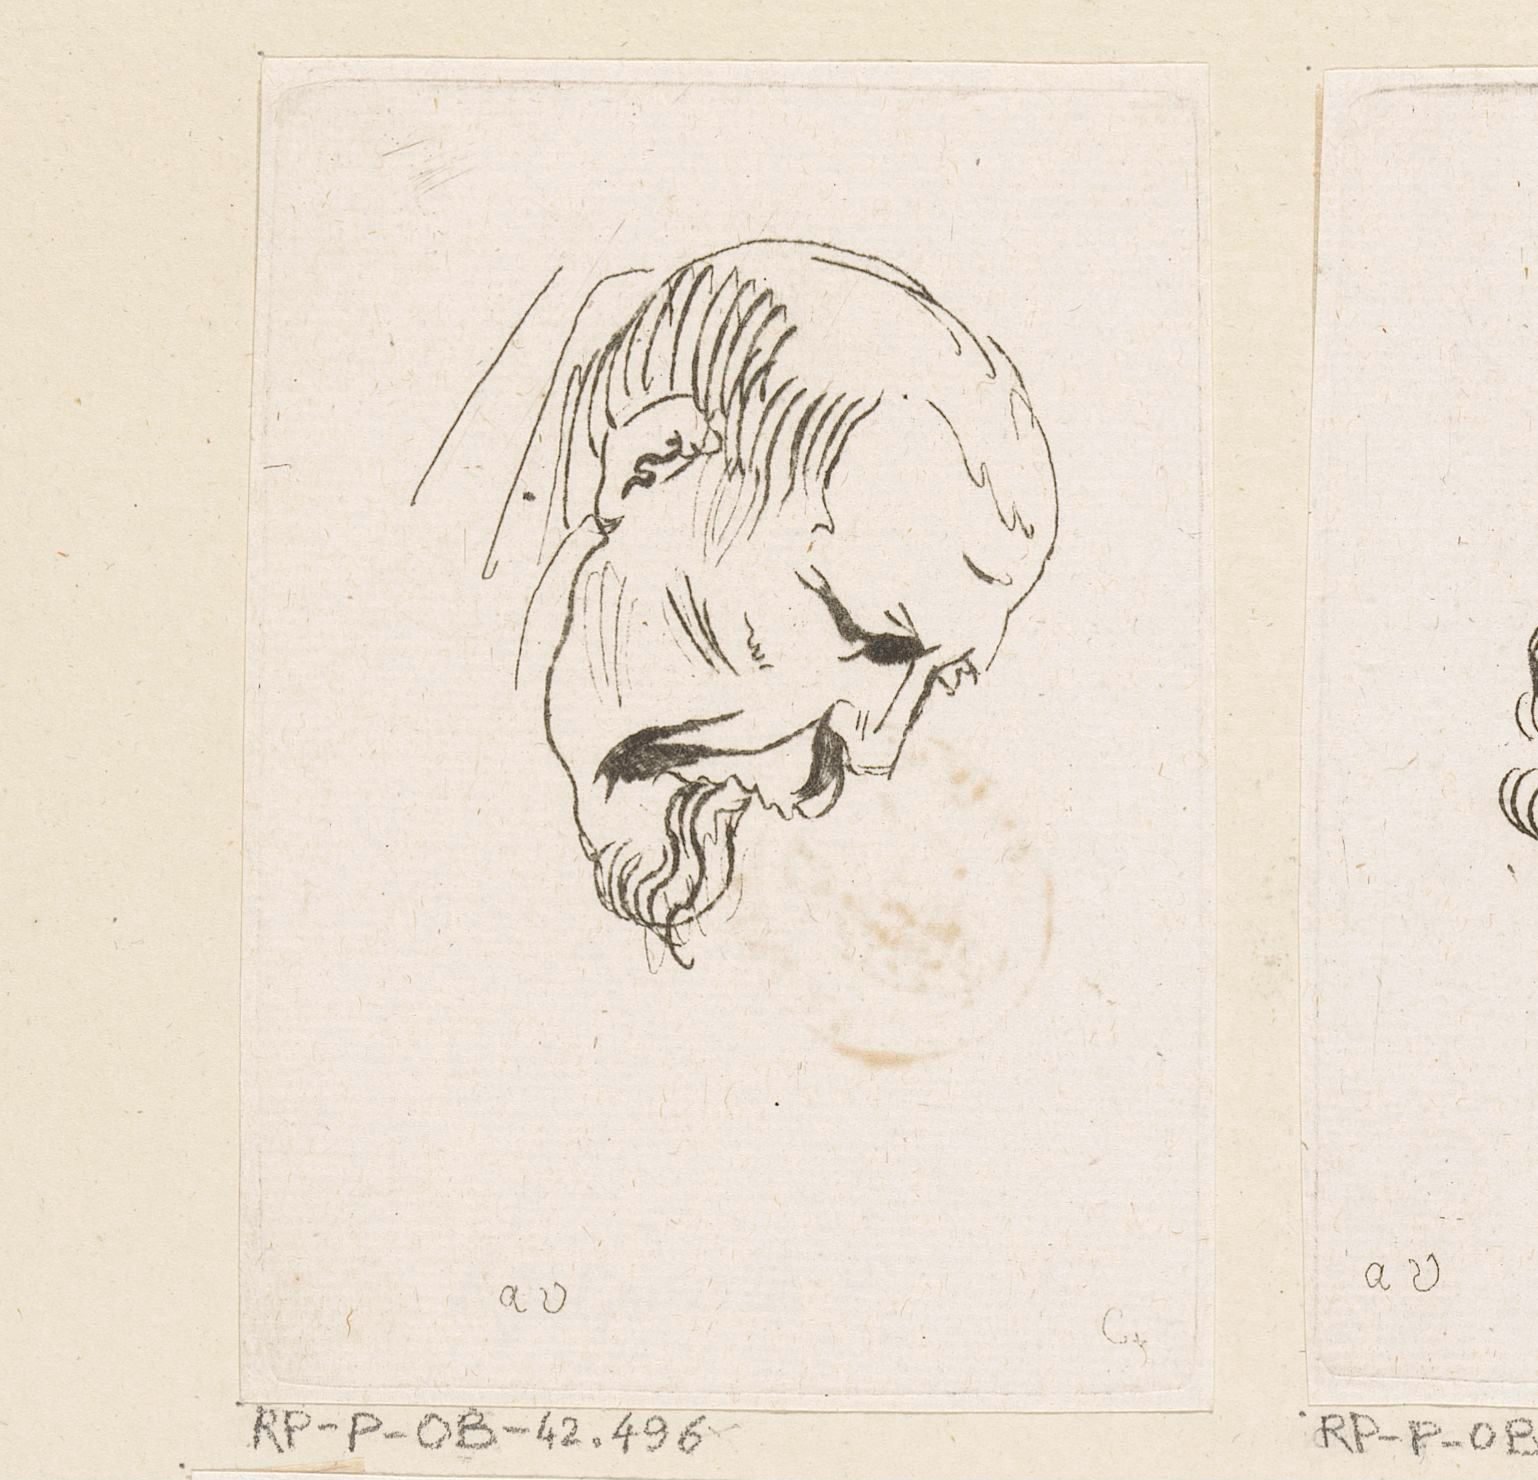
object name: print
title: Recueil de Testes d'Antoine Van Dyck (...)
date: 1735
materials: paper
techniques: etching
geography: france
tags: head (human), old man, beard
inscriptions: collector's mark: Lugt 240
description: Prent uit een serie van 31 prenten naar getekende hoofden door Van Dyck, plus een titelprent naar Bouchardon, getiteld: "Recueil de Testes d'Antoine Van Dyck tirées du Cabinet de M. Crozat et gravées par M. le C. de C.".